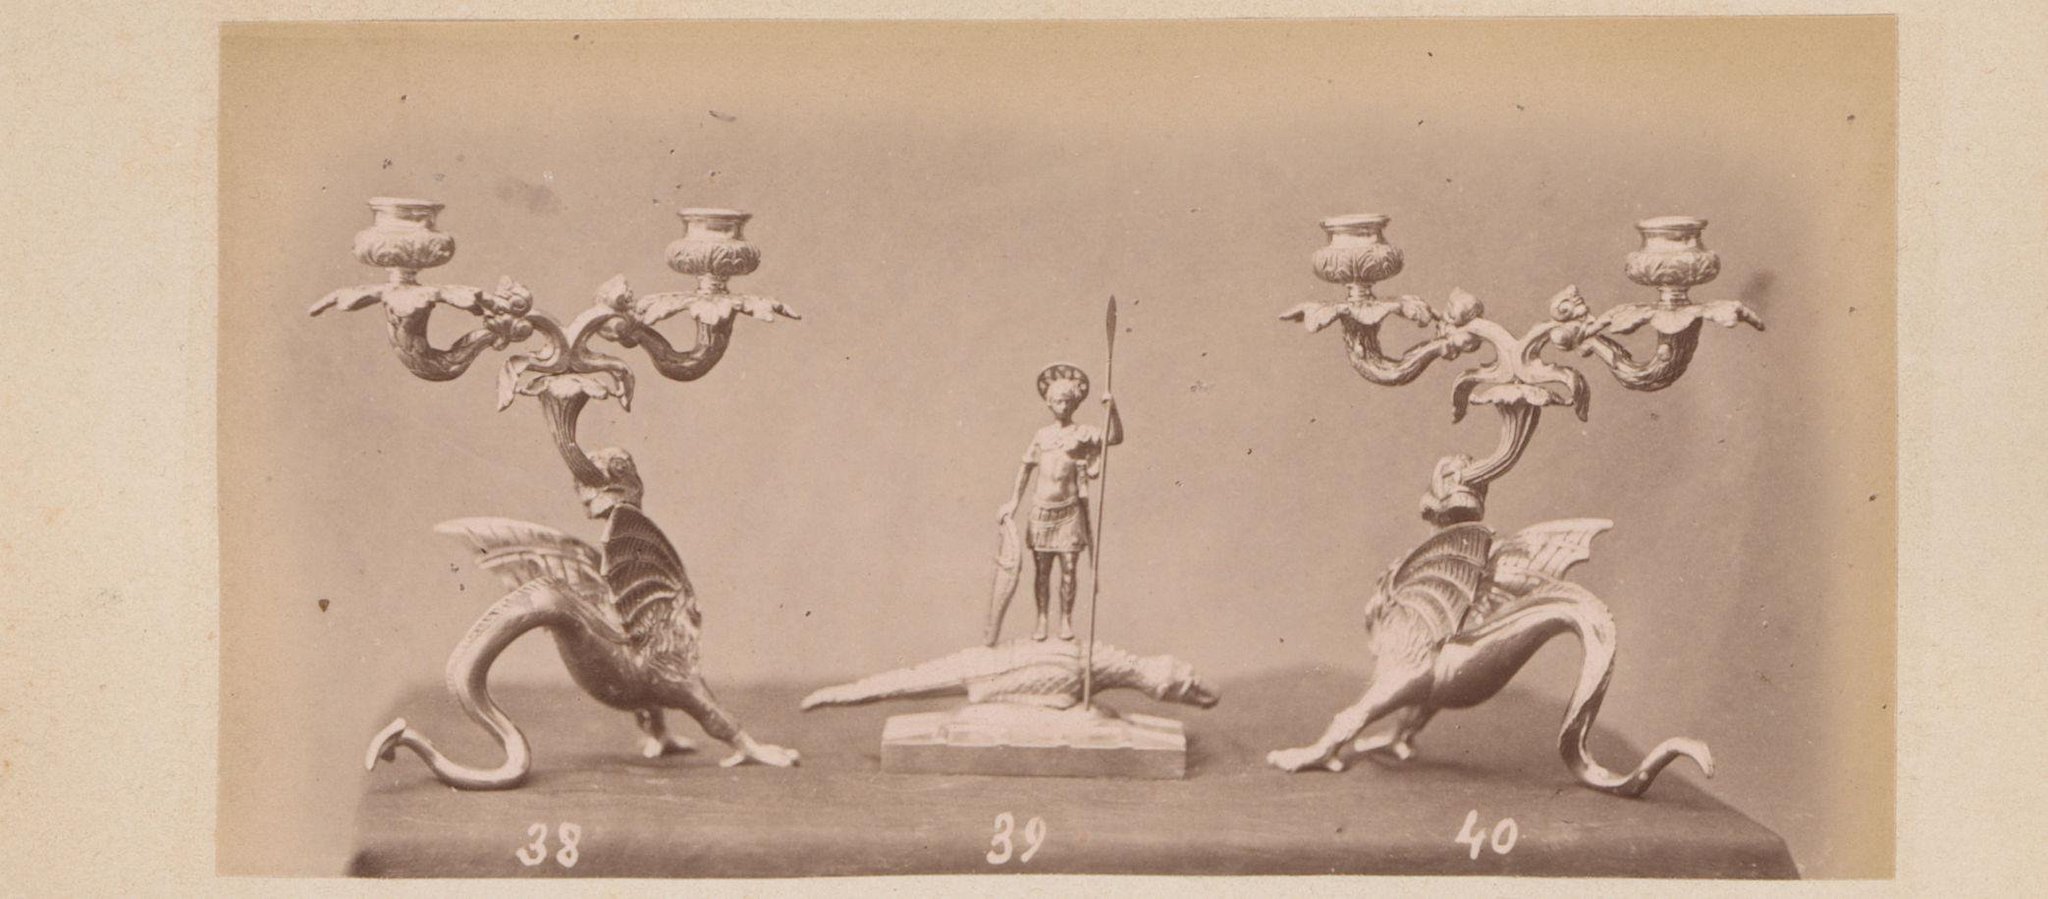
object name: page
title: Metalen kandelaars in de vorm van griffioenen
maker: Anonymous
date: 1860-1885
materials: photographic support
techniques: albumen print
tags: chandelier, candelabrum